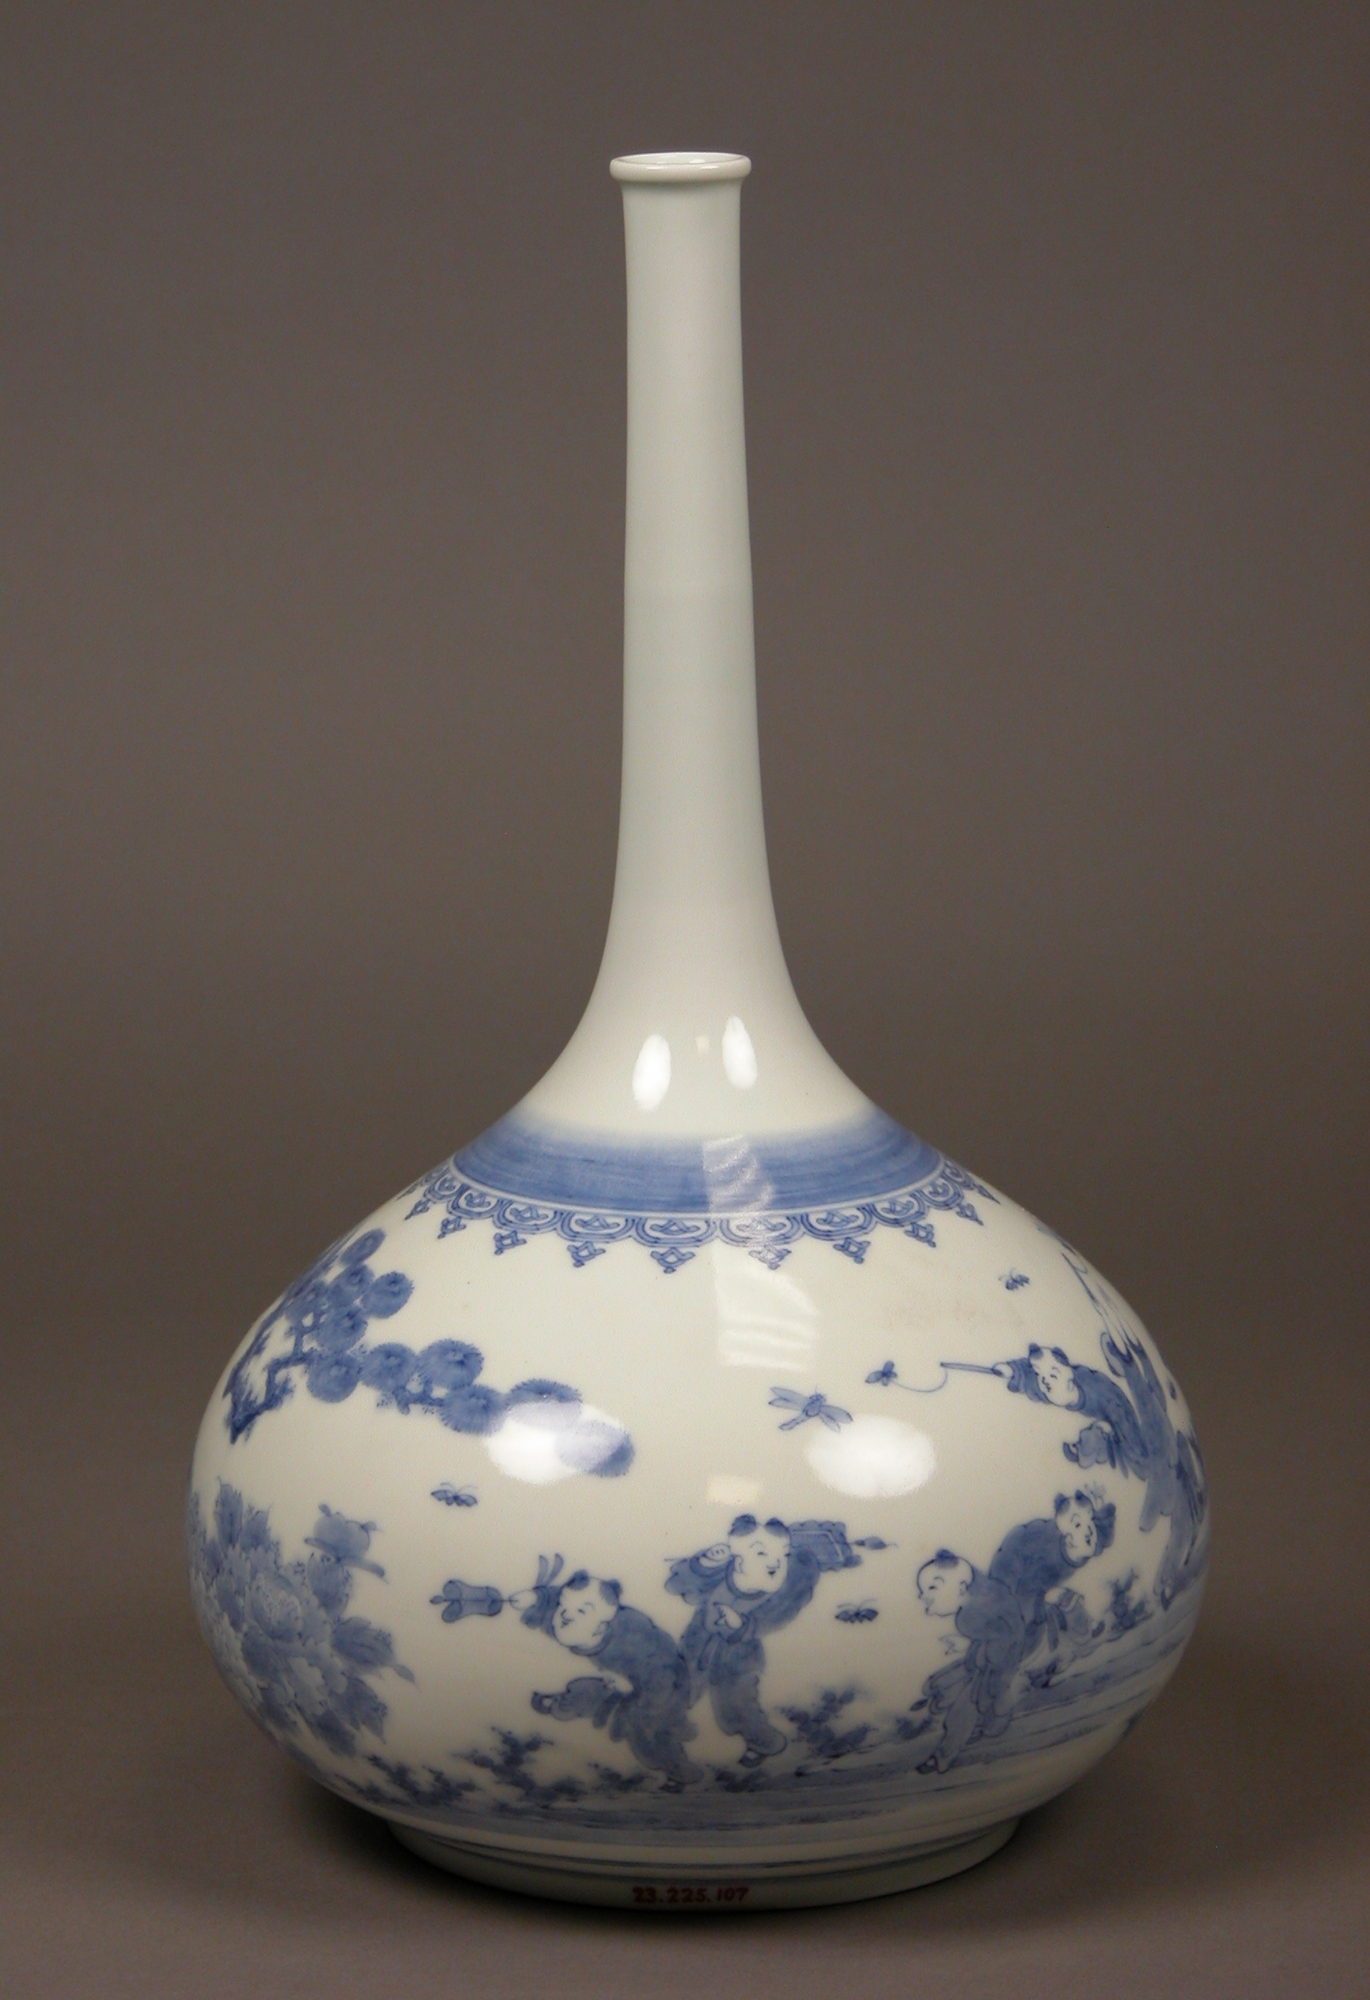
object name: bottle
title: Long-Necked Bottle with Design of Chinese Children Playing Outdoors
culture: japanese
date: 1801-1900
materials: porcelain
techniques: underglaze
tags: children,playing,butterflies,trees